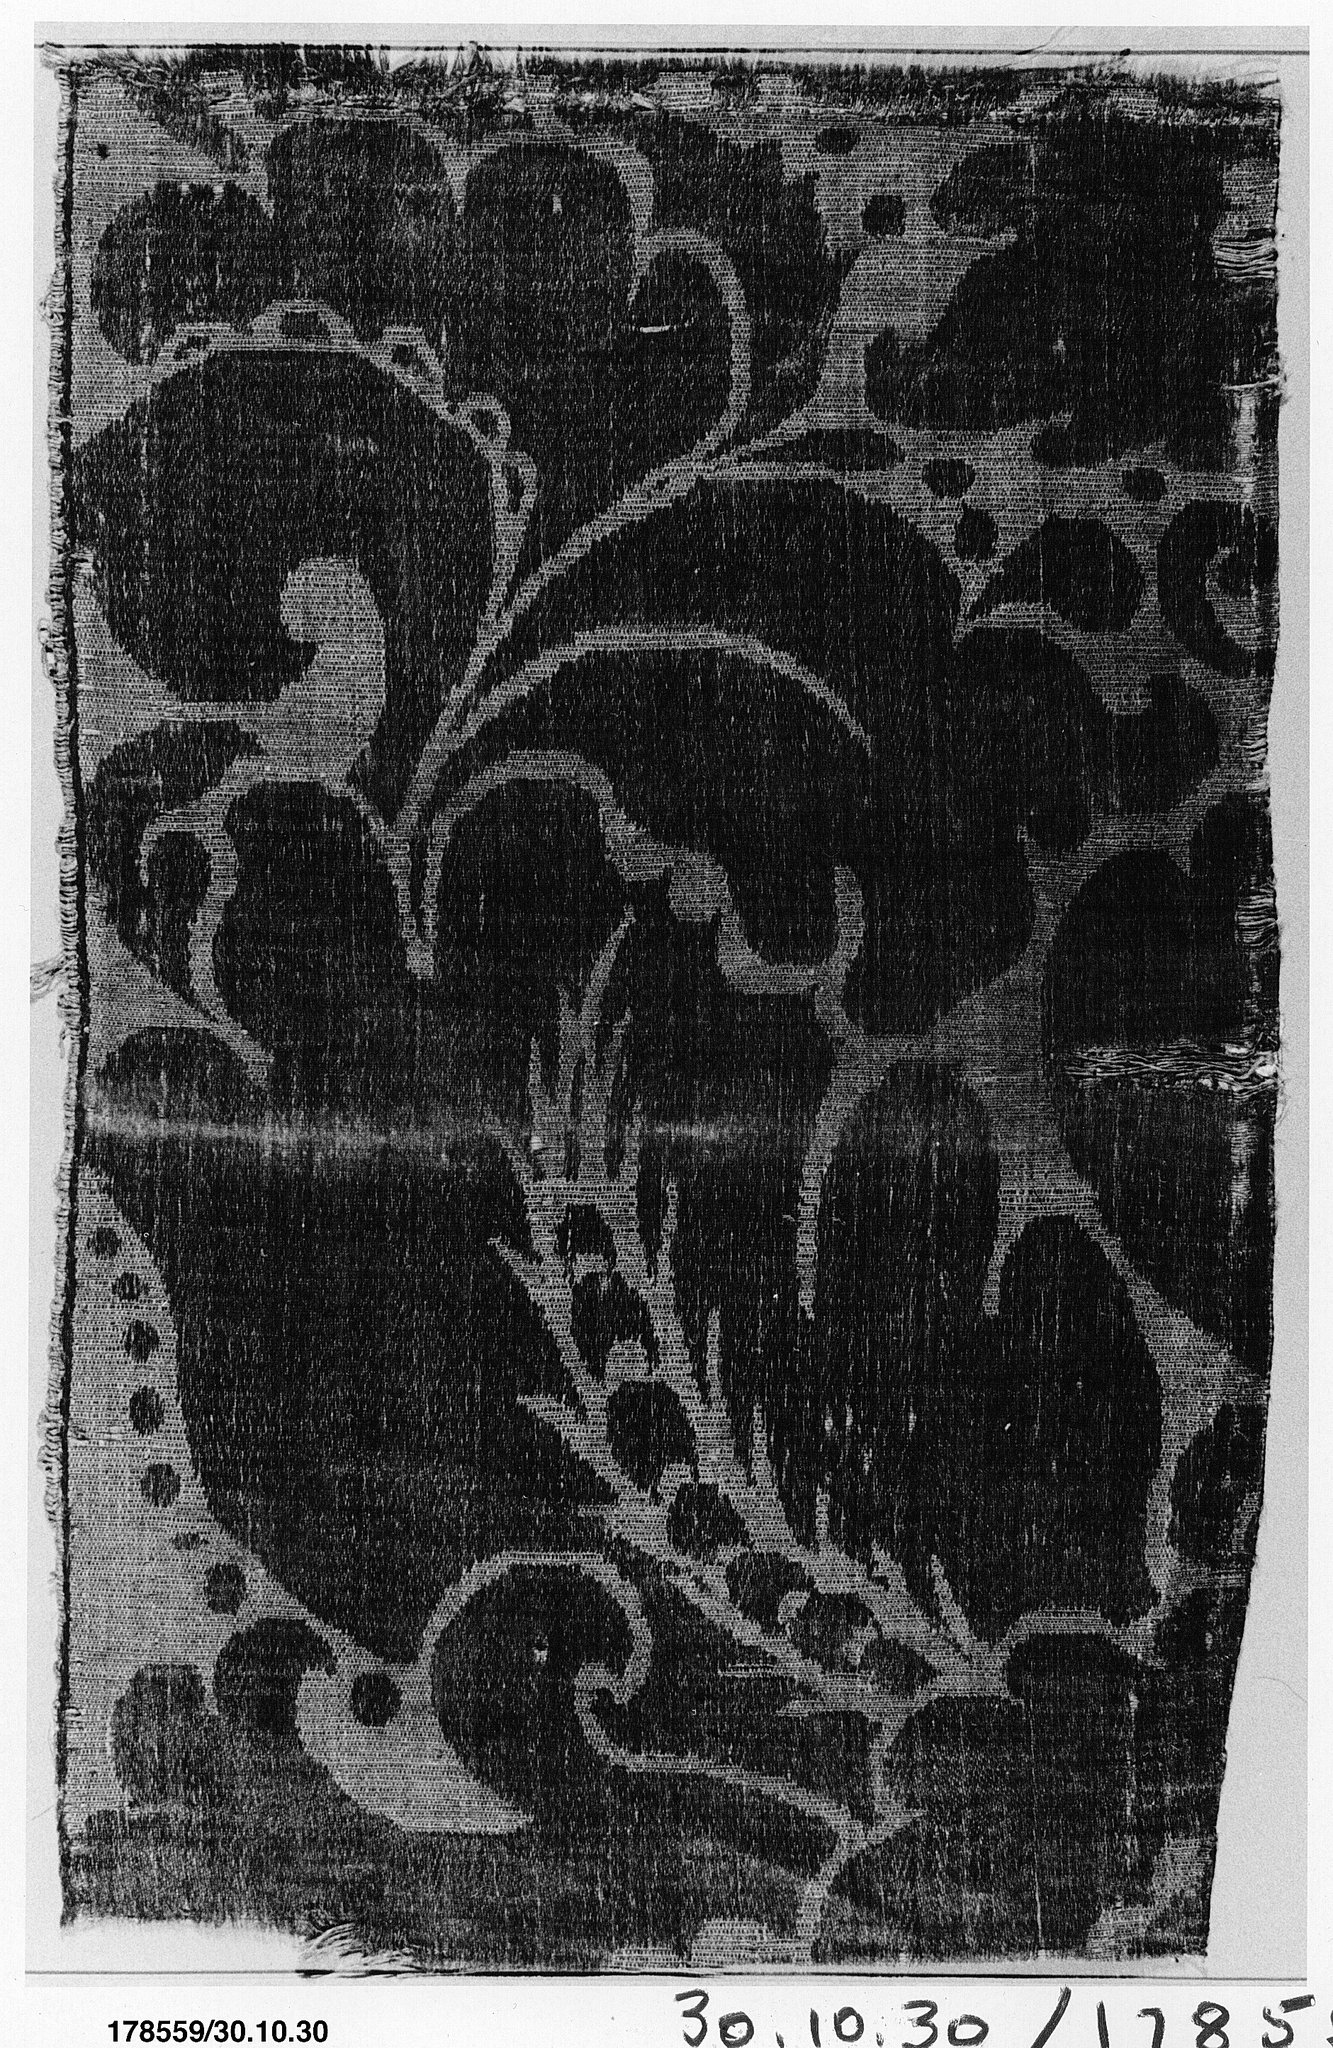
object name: piece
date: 1701-1800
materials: linen, silk